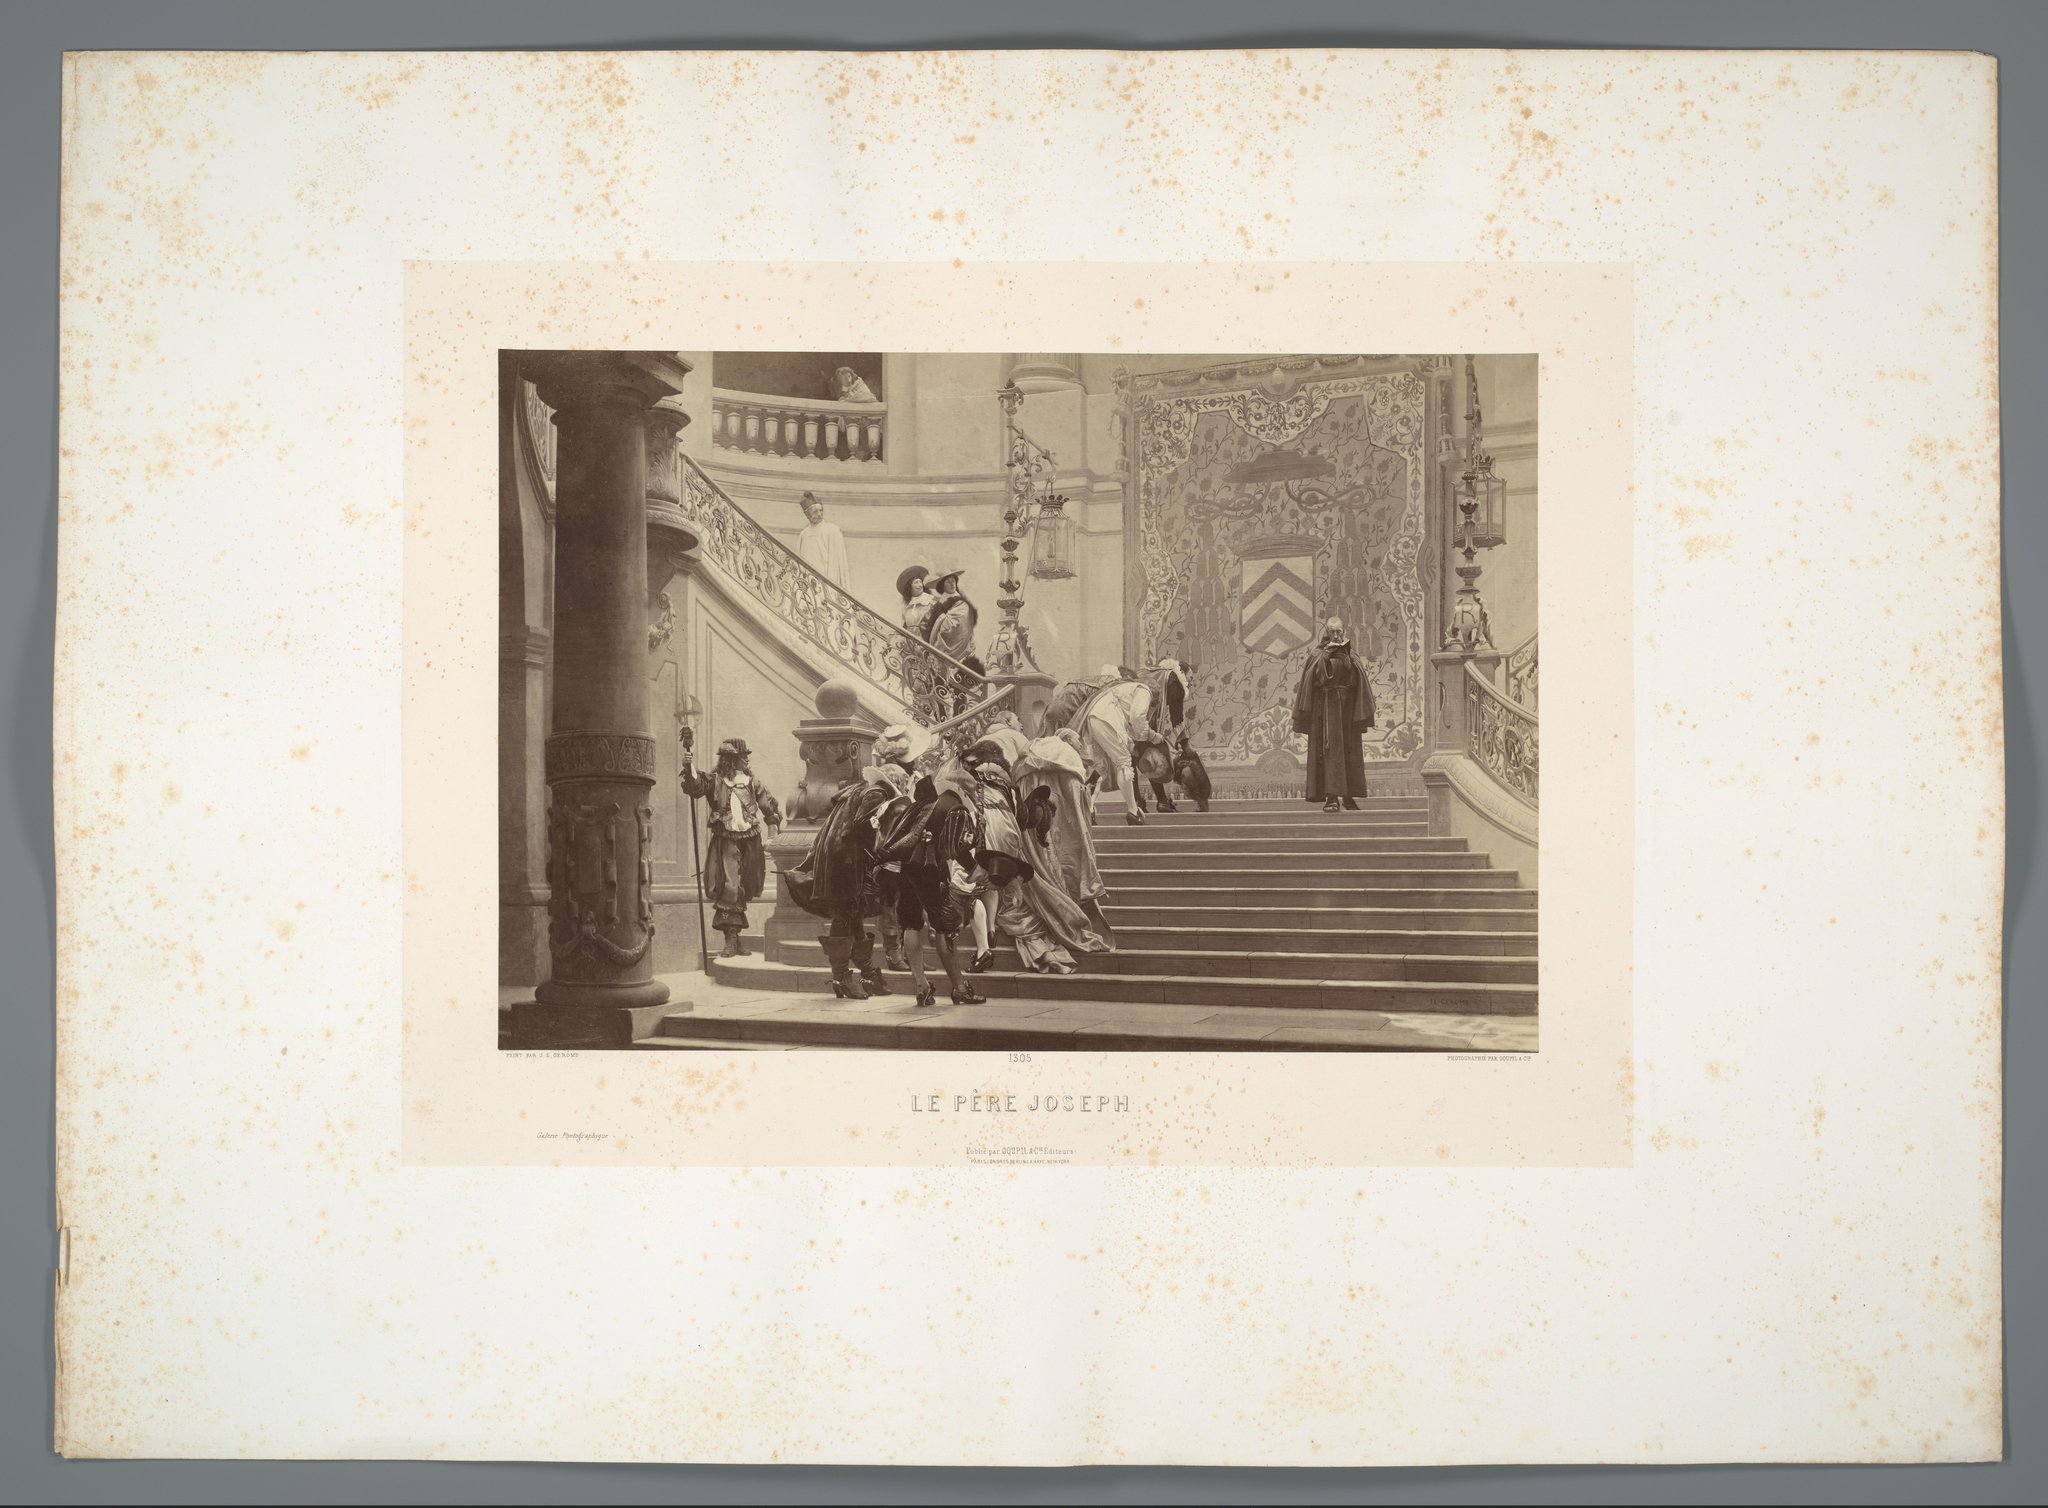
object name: photograph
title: Galerie Photographique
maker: jean-léon gérôme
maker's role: draughtsman, painter, print maker, sculptor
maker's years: 1824-1904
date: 1873-1884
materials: cardboard, paper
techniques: albumen print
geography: paris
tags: court ceremonial, court etiquette, cardinal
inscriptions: number: ‘1305’